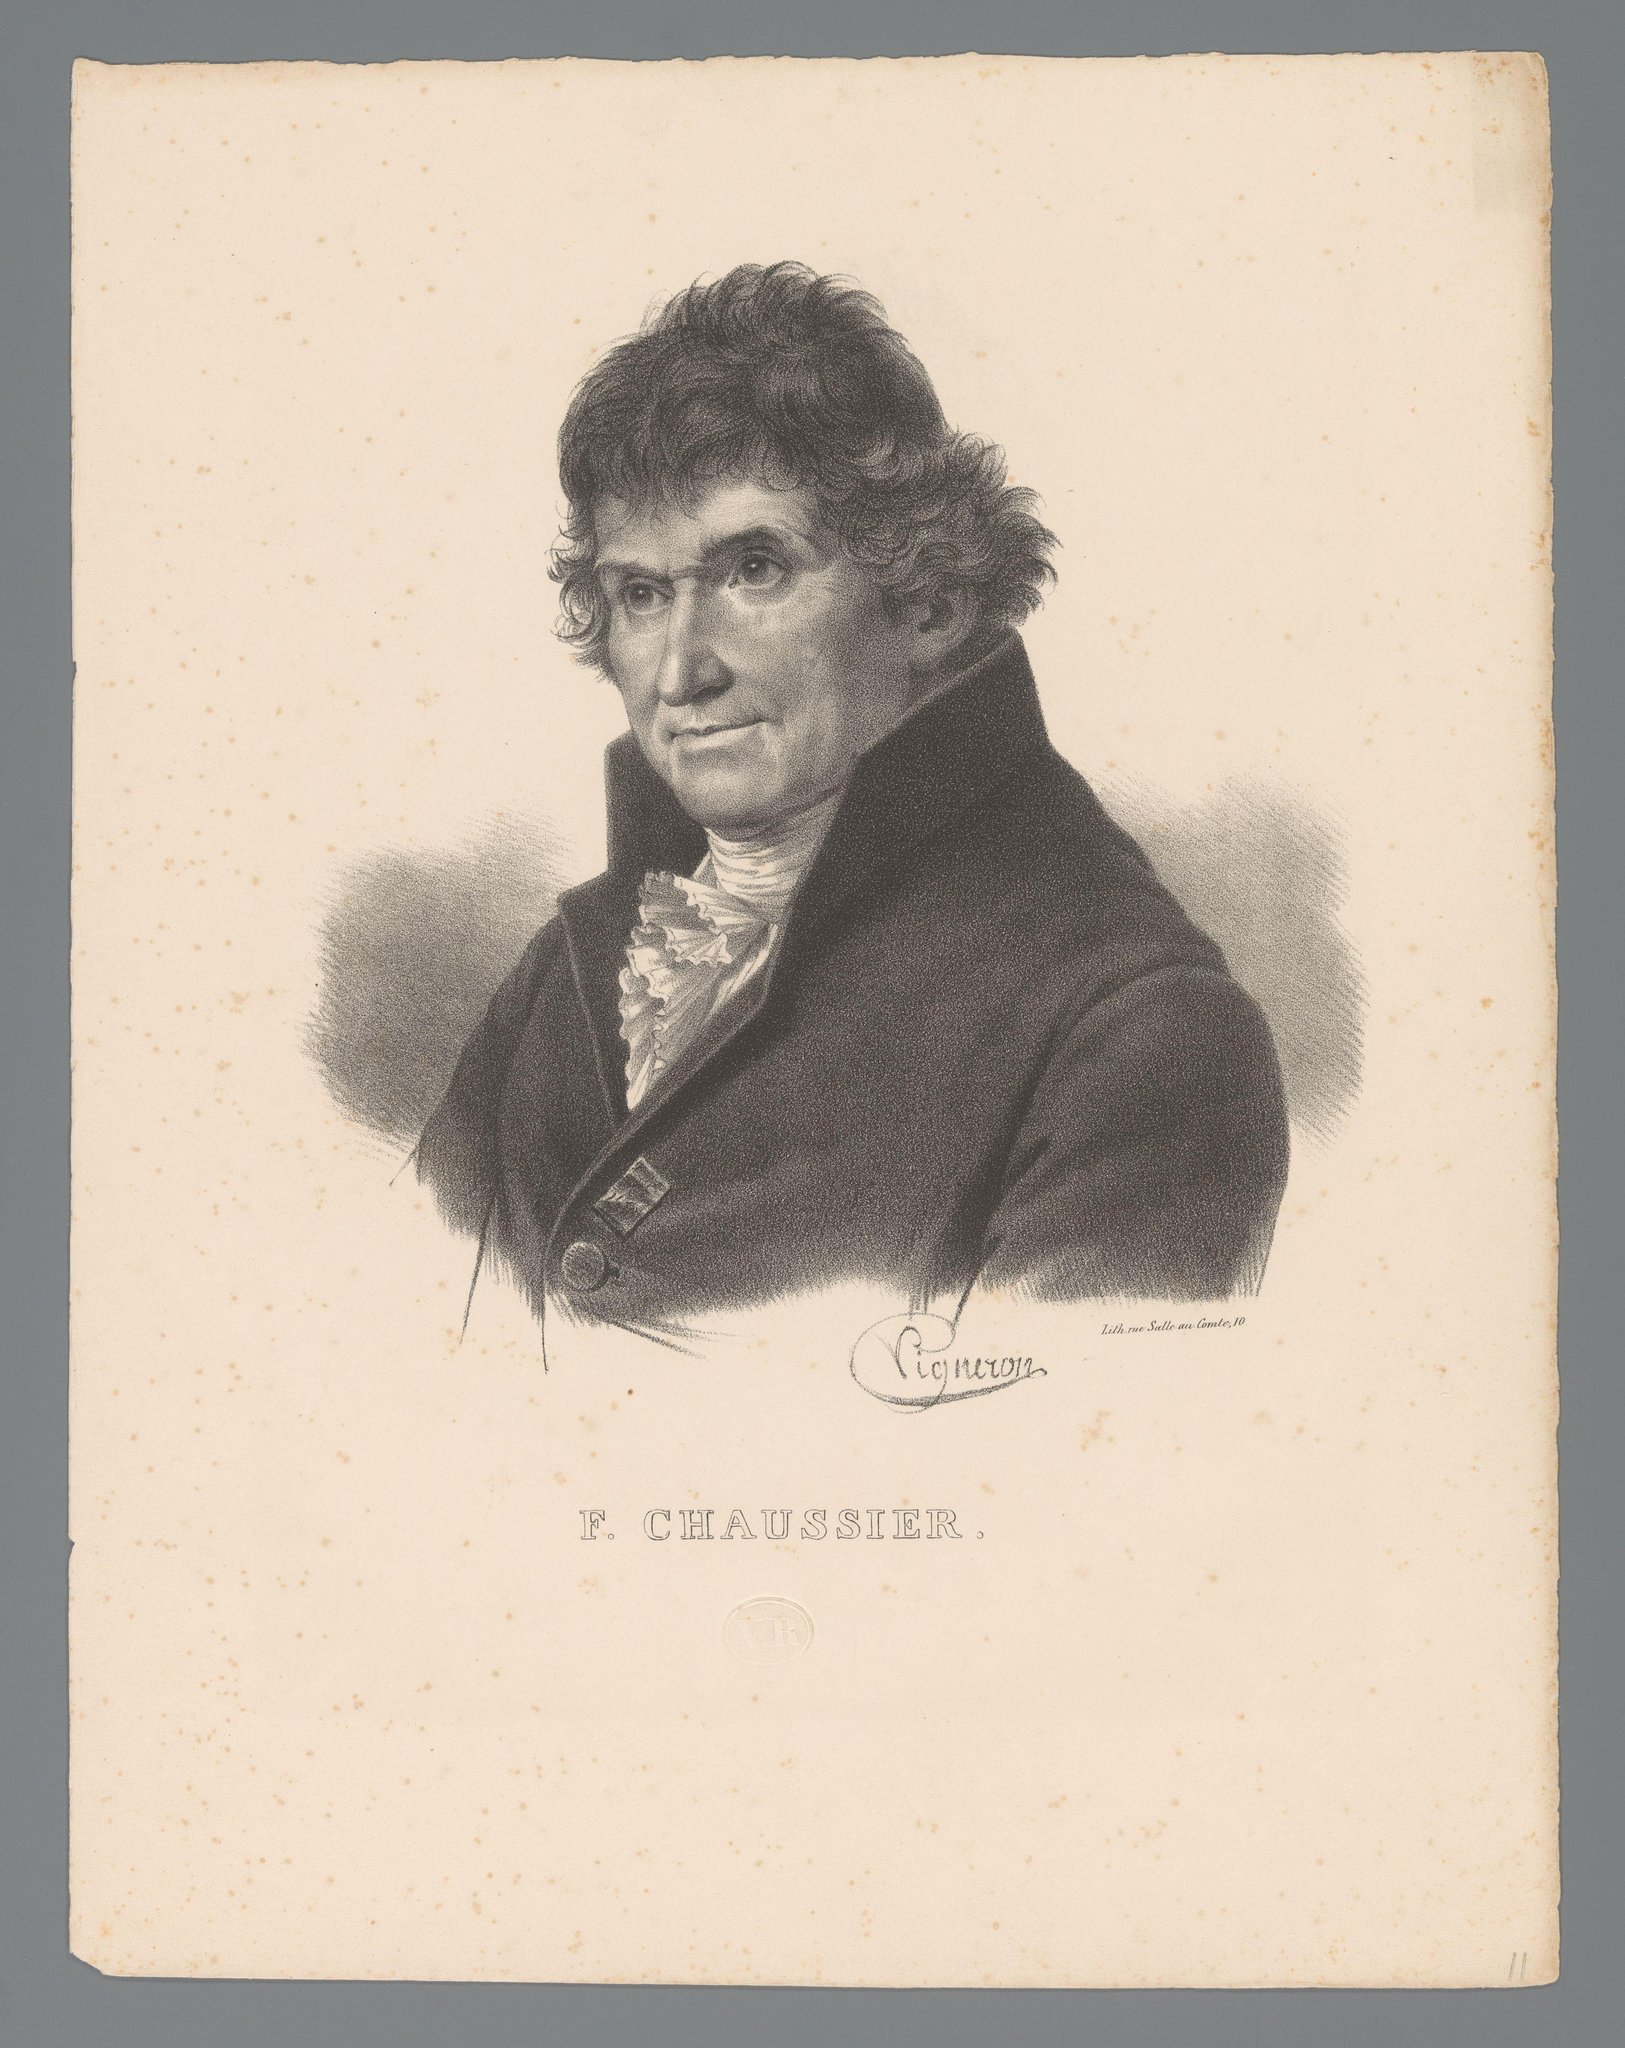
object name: print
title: F. Chaussier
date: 1830-1853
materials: paper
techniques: lithograph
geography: paris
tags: paris, historical persons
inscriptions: check stamp: Lugt 3693, collector's mark: Lugt 2228